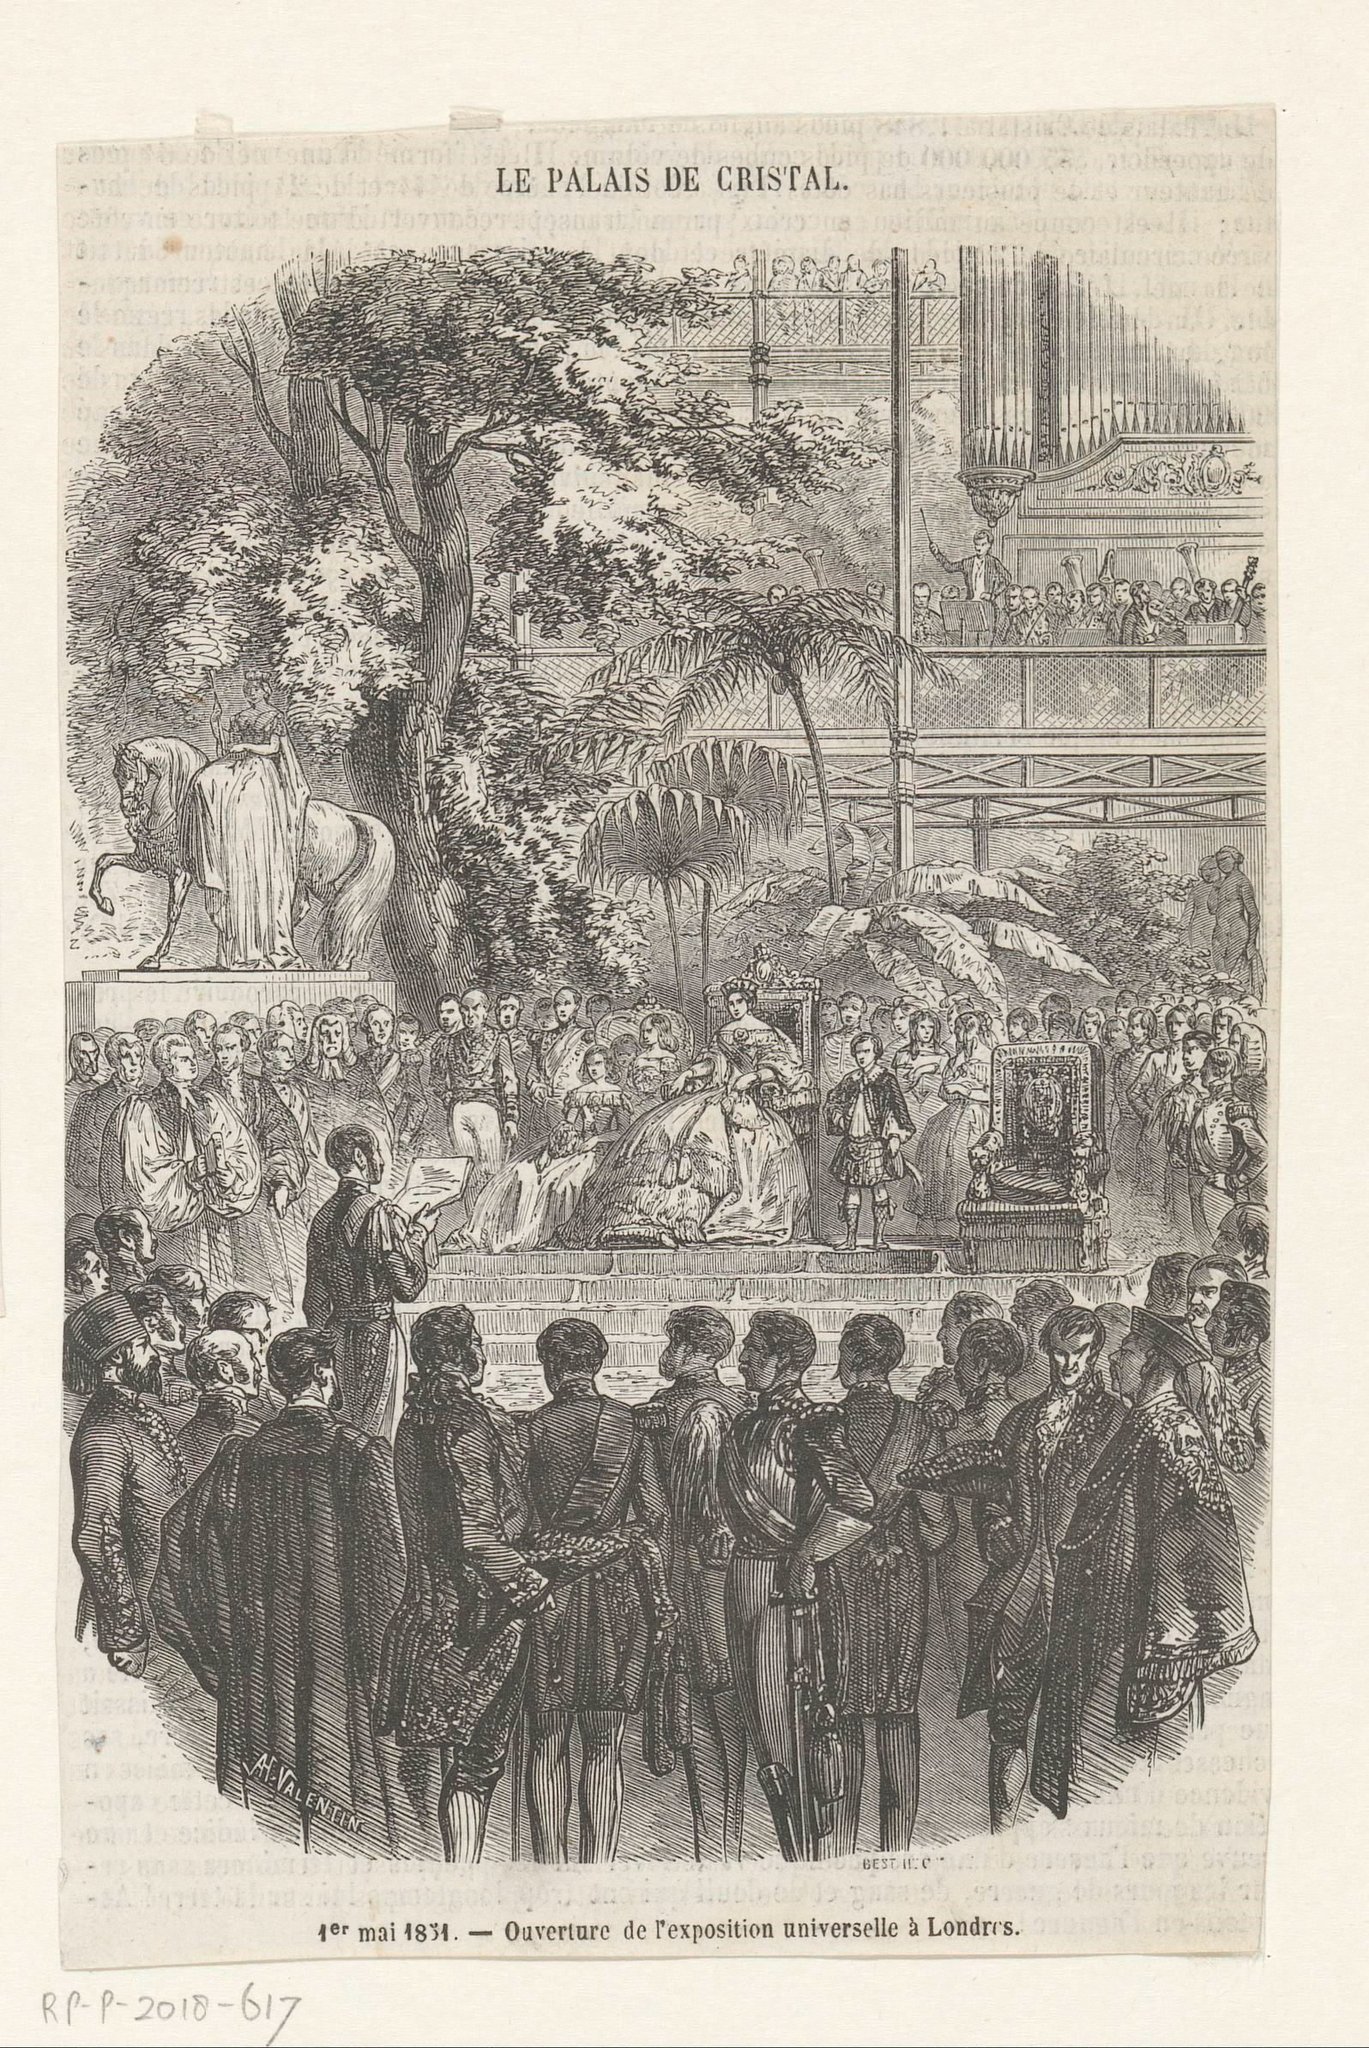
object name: print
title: Opening van de wereldtentoonstelling in Crystal Palace door koningin Victoria, 1851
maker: henry augustin valentin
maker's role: painter, print maker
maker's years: 1822-1886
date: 1851-1855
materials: paper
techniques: engraving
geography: france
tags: victoria (koningin van het verenigd koninkrijk en keizerin van india), world fair, world exhibition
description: Opening van de Great Exhibition (Crystal Palace Exhibition), de wereldtentoonstelling in Crystal Palace door koningin Victoria, 1 mei 1851. Op achterzijde bedrukt met tekst.